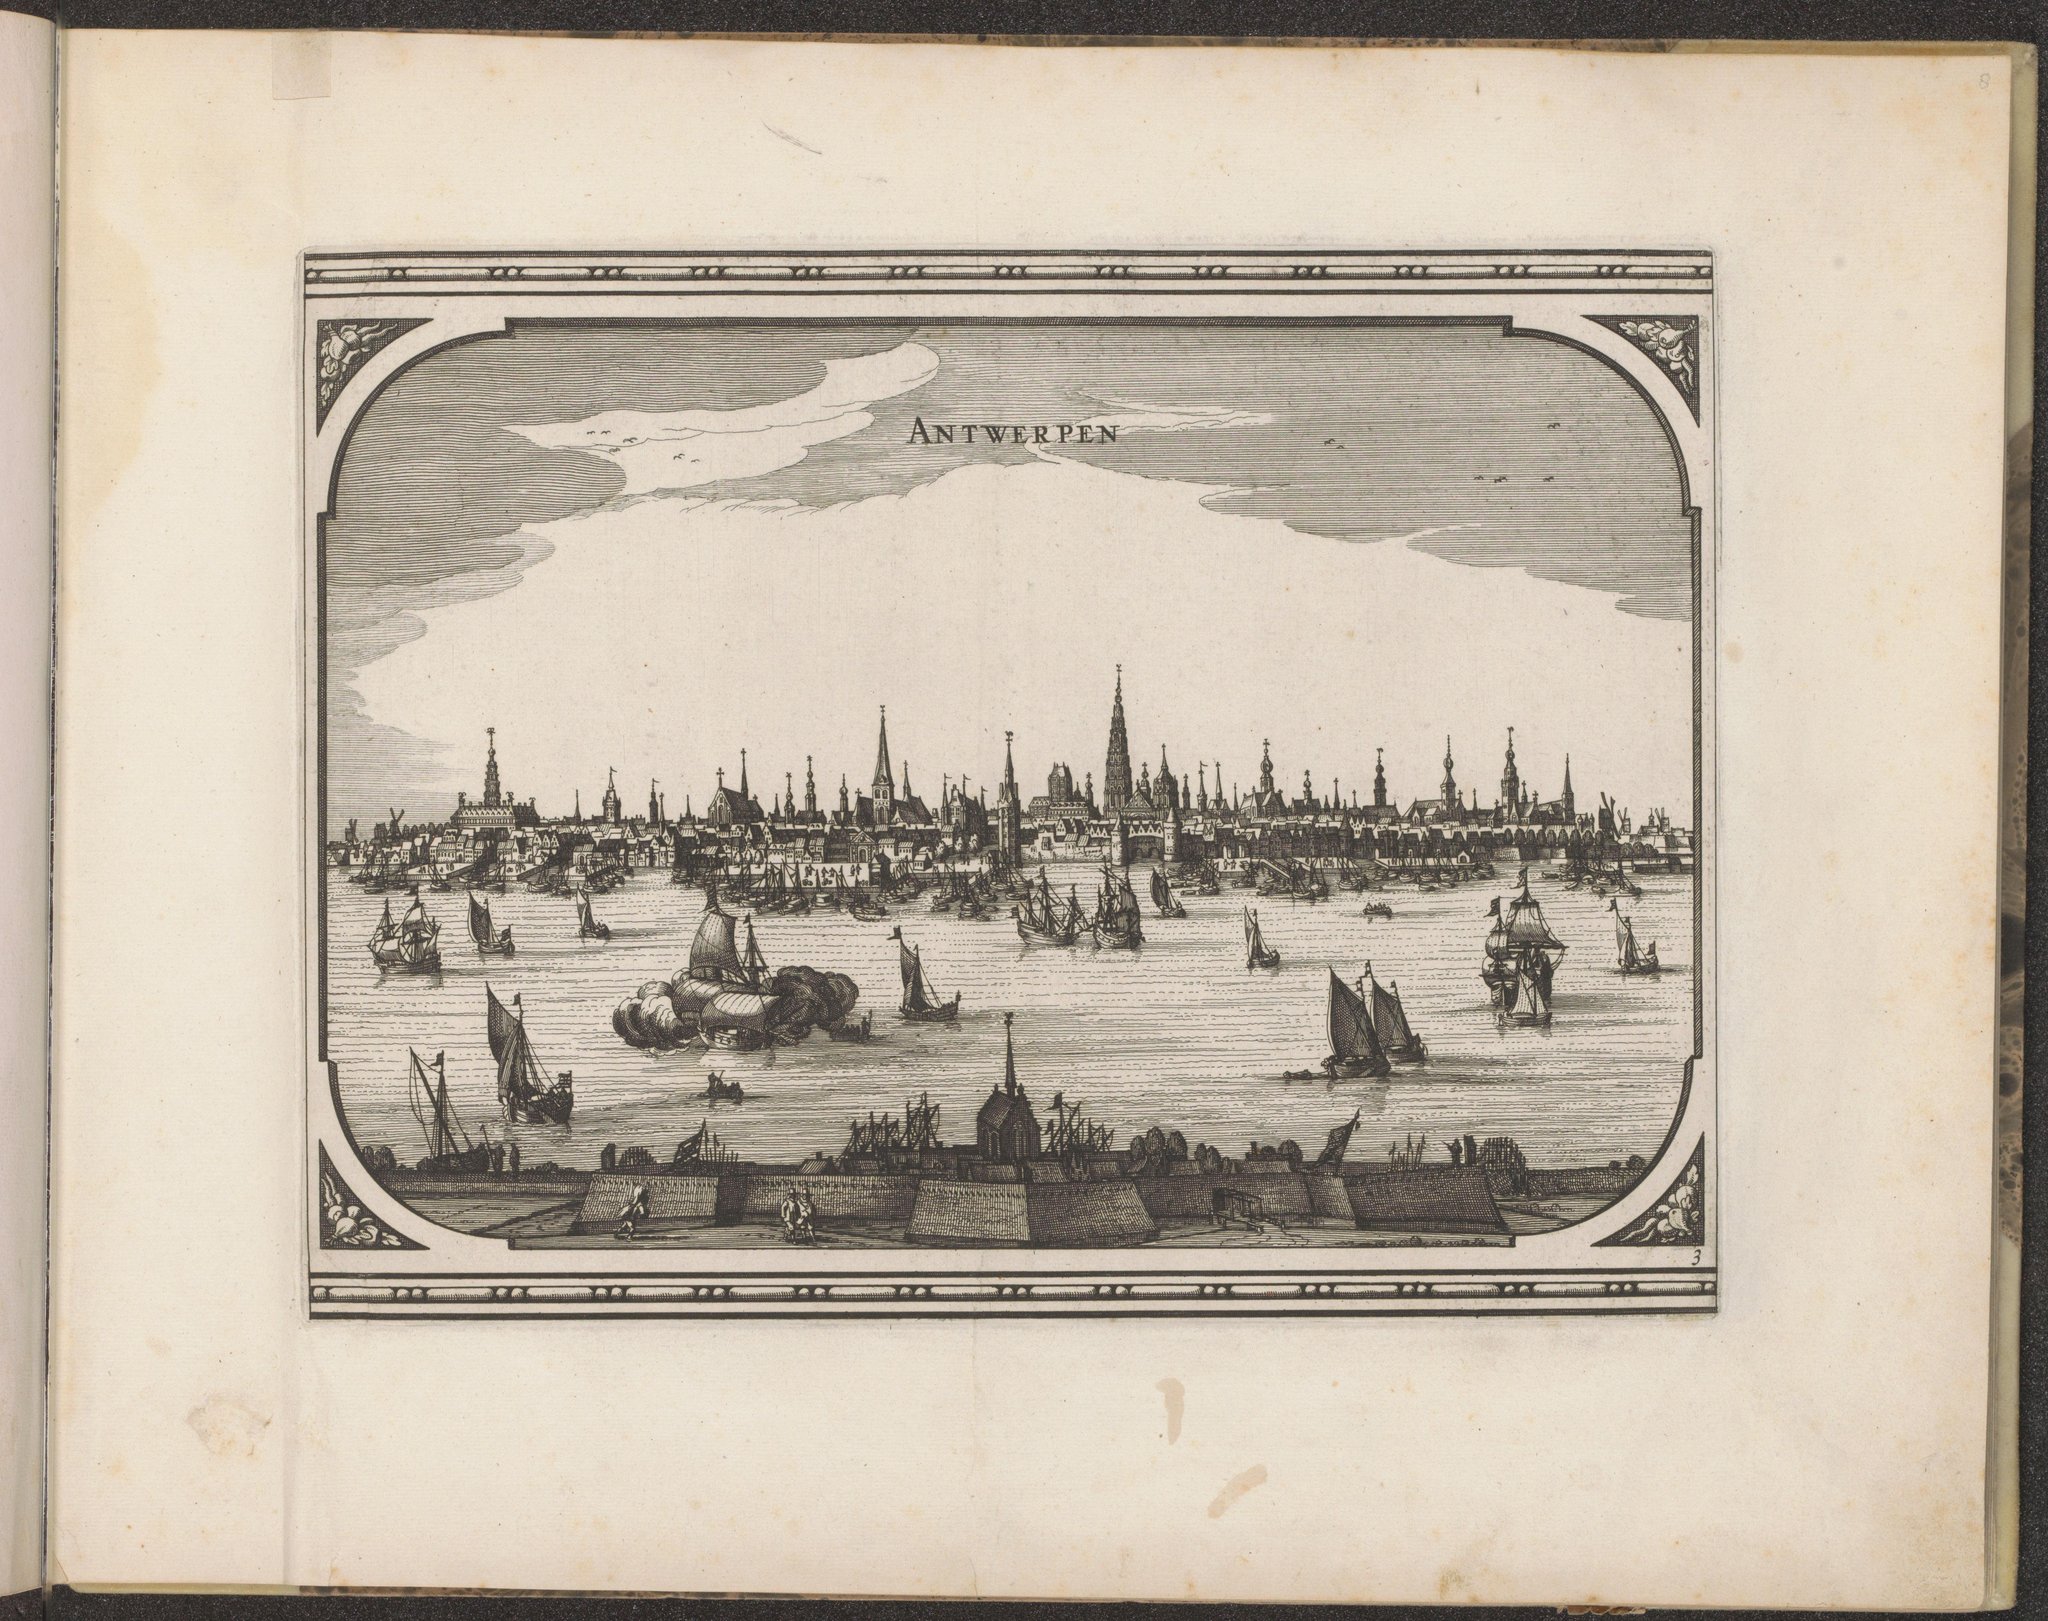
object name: print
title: Gezicht op Antwerpen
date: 1660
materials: paper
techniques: etching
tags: city-view, and landscape with man-made constructions, river, ships (in general), fortifications, military engineering, antwerp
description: Gezicht op de stad Antwerpen vanaf een fort aan de overkant van de drukbevaren Schelde. De prent maakt deel uit van een album.